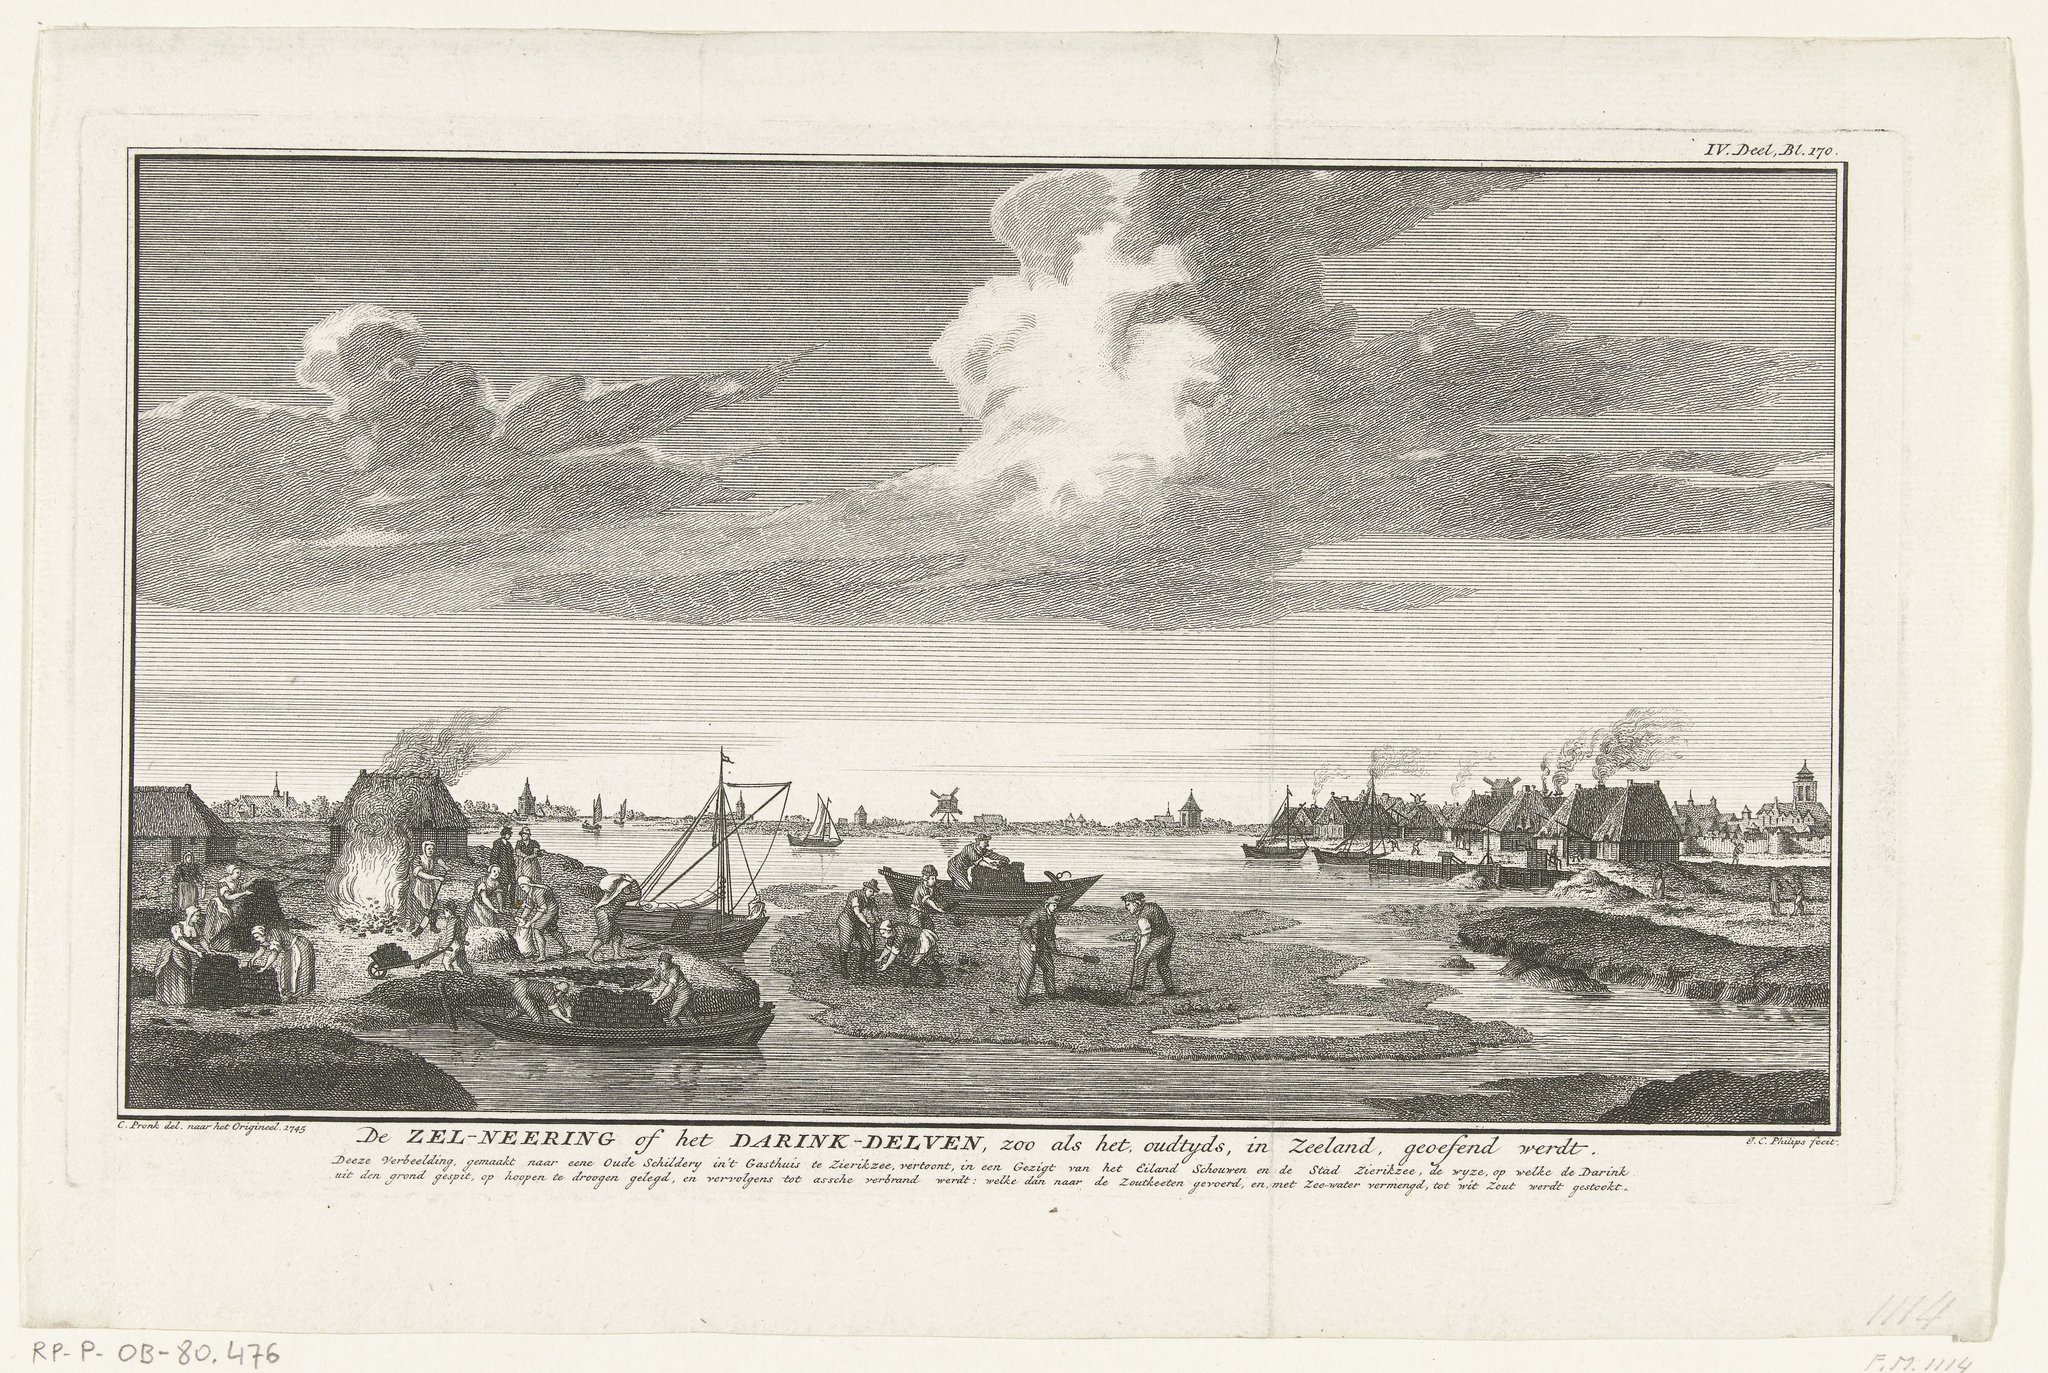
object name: print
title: De zel-neering of het darink-delven, zoo als het oudtyds, in Zeeland, geoefend werdt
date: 1750-1770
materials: paper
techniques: engraving, etching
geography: amsterdam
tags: opencast mine; strip mining, salt, zeeland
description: Huidige staat van prent ook gebruikt in: Wagenaar, Jan. Vaderlandsche historie, vervattende de geschiedenissen der Vereenigde Nederlanden […]. 21 delen. Amsterdam: Isaak Tirion, 1749-1759, dl. 4 (1750), p. 170. En in: Wagenaar, Jan. Vaderlandsche historie, vervattende de geschiedenissen der nu Vereenigde Nederlanden […]. 21 delen. Amsterdam: weduwe Isaak Tirion, 1770, dl. 4, p. 170. Prent naar het anonieme zestiende-eeuwse schilderij op paneel in de Burgemeesterskamer van het oude stadhuis van Zierikzee.